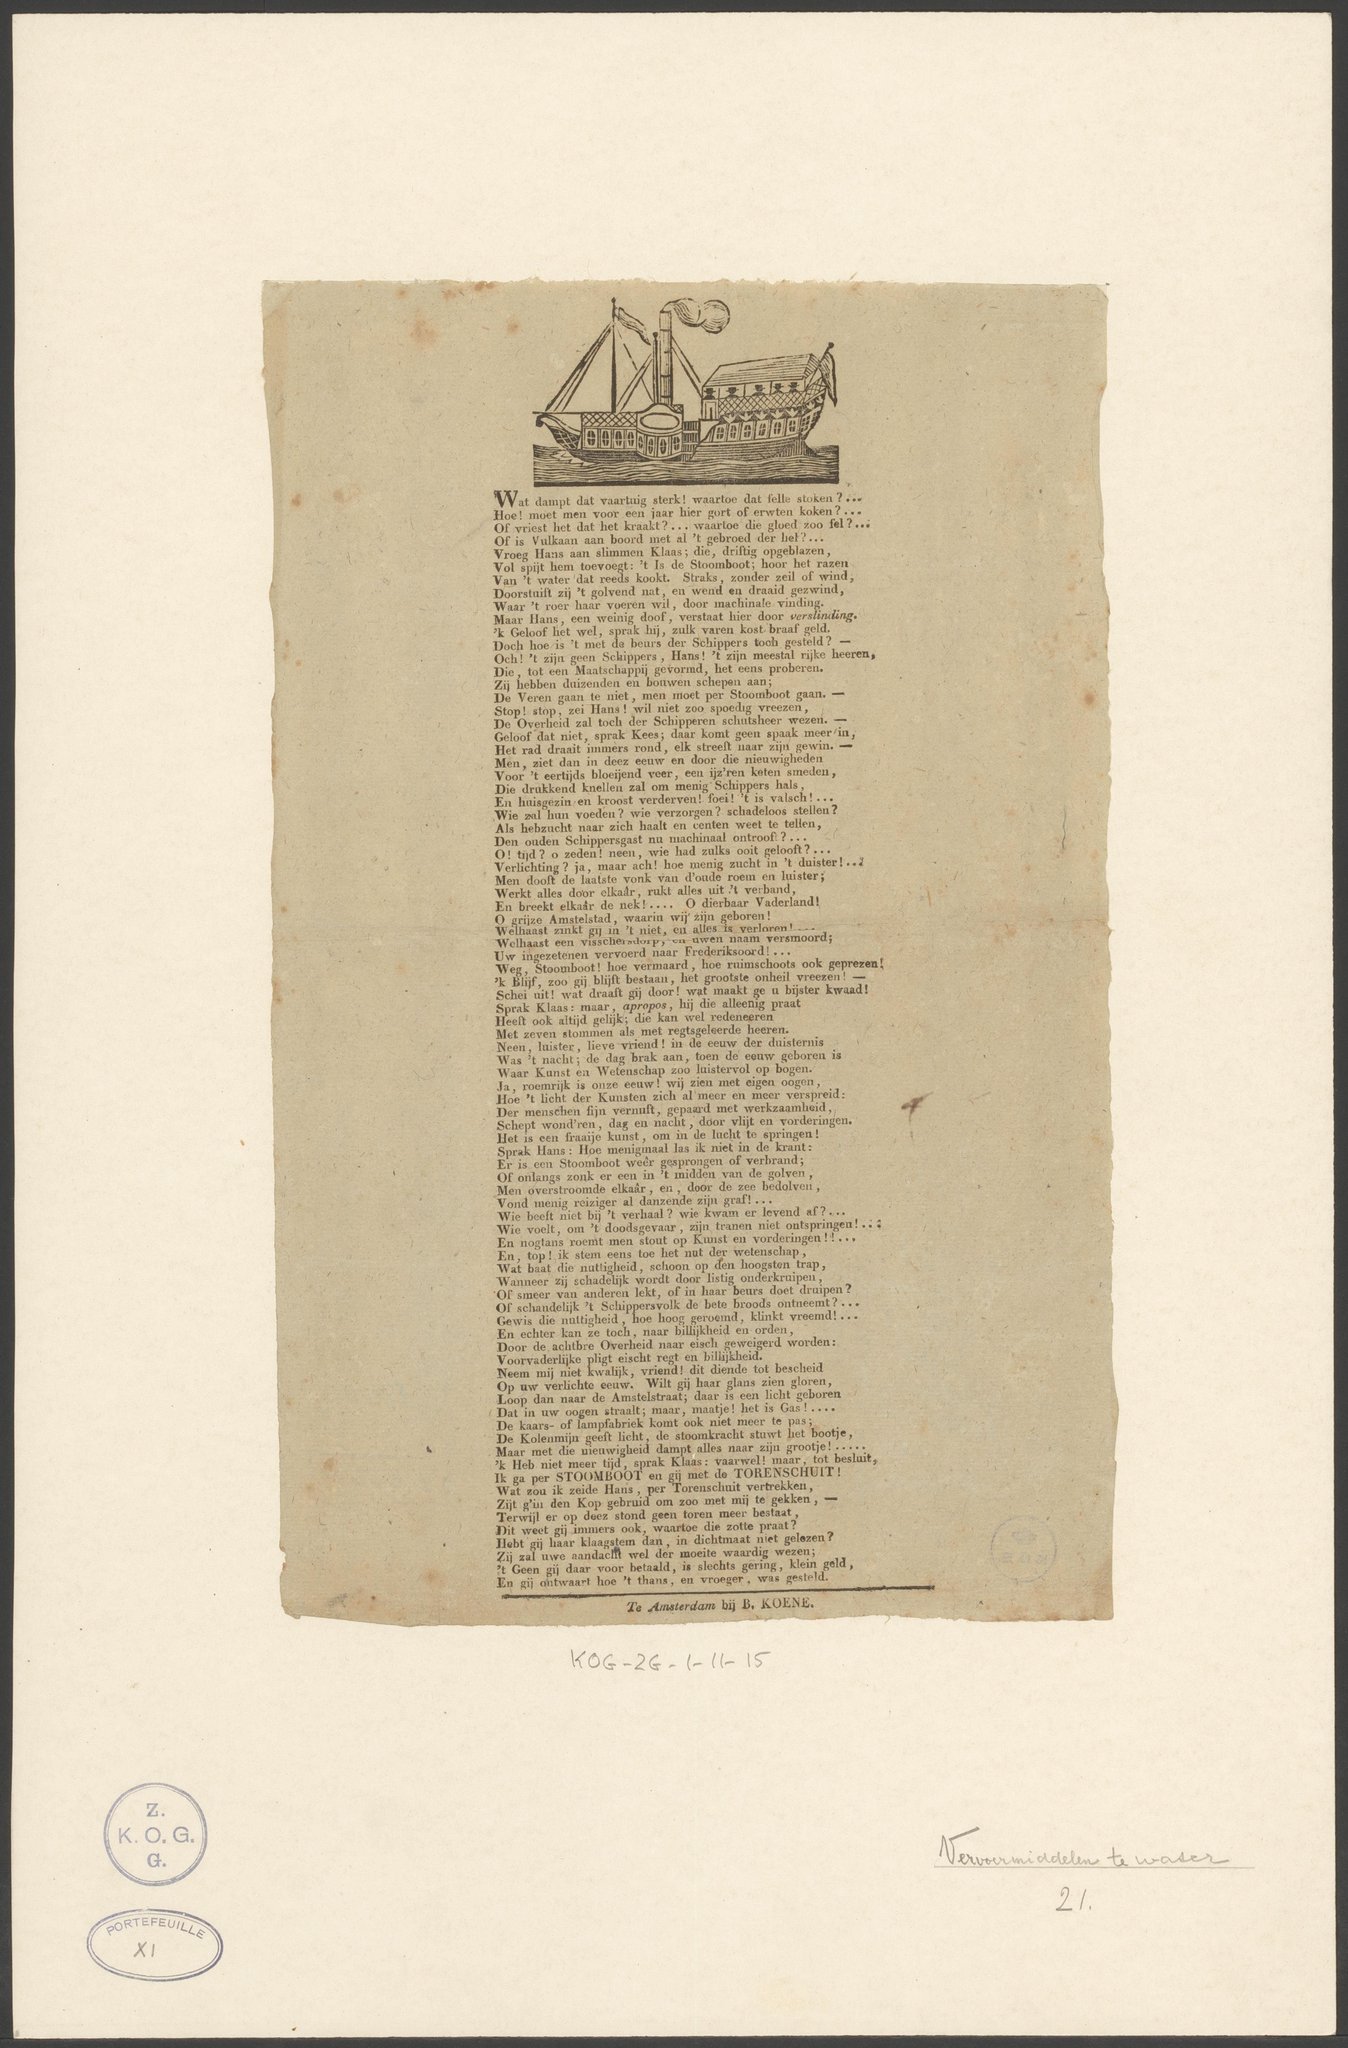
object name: print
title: Samenspraak tussen Jaap en Klaas over de Stoomboot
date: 1810-1830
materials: paper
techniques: letterpress printing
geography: amsterdam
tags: passenger liner, traffic on the water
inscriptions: collector's mark: Lugt 1641a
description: Onderwerpsrubrieken binnen de Atlas Zeden en Gewoonten: Handel, nijverheid en verkeer, Vervoermiddelen te land en te water, Vervoermiddelen te water.